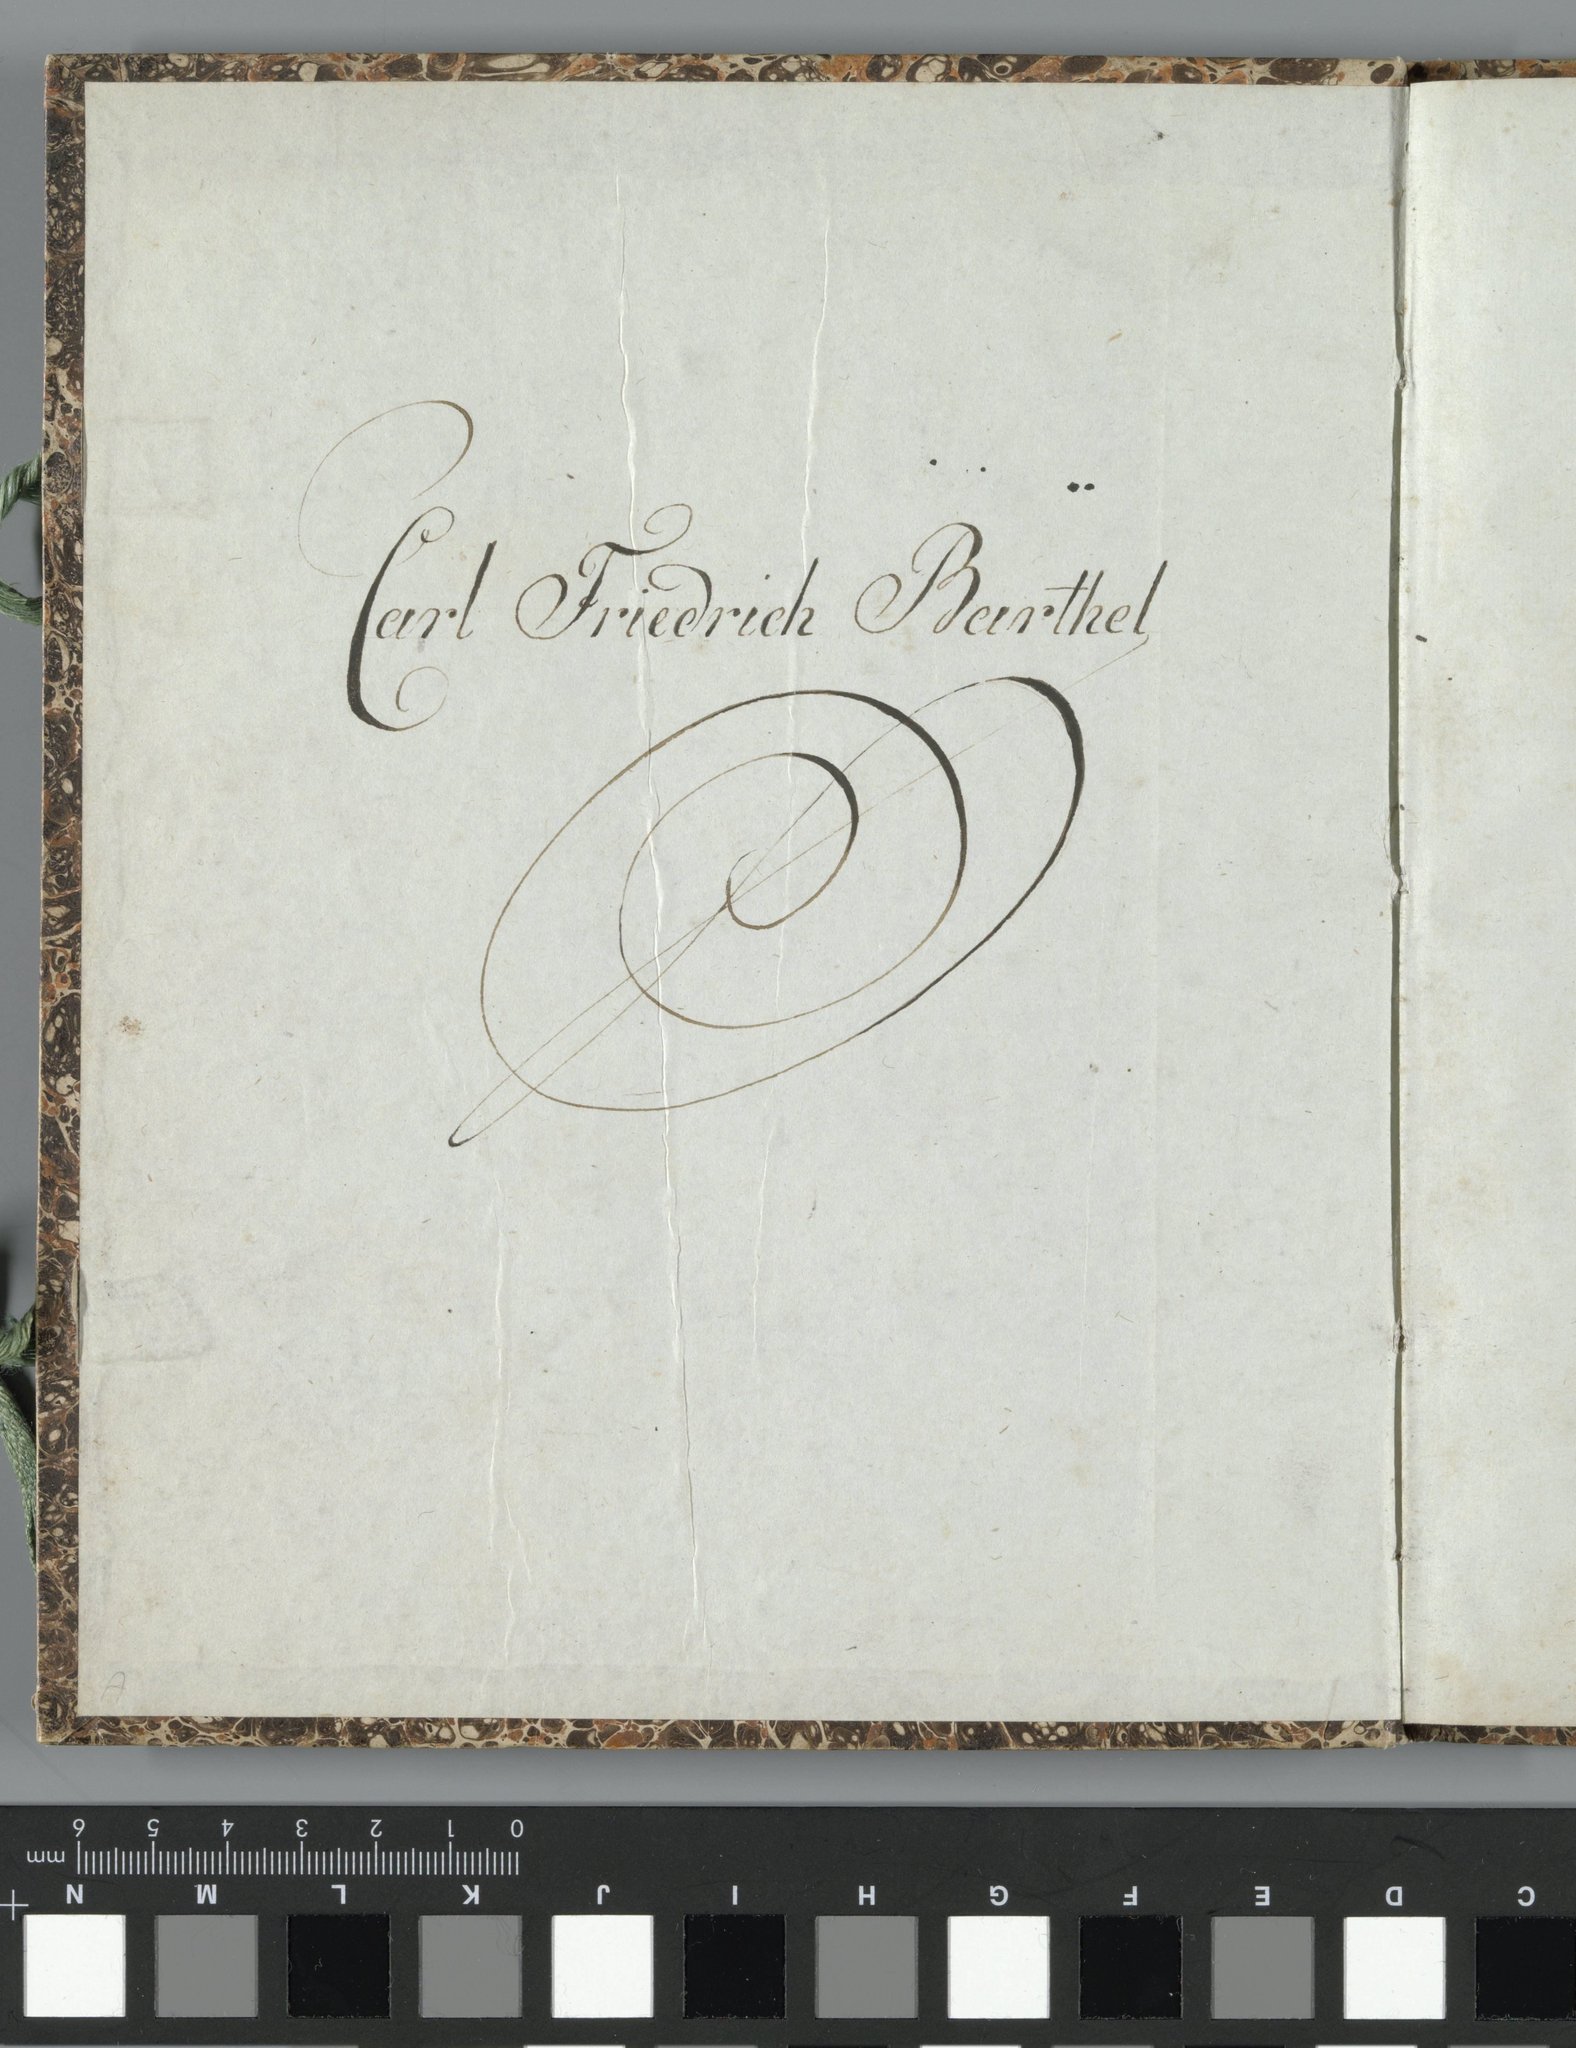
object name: endleaf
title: Schutblad uit een band met 17 bladen met tekeningen van juwelen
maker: carl friedrich bärthel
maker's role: draughtsman, jeweler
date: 1800-1810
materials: ink, paper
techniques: pen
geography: augsburg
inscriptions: signature: ‘Carl Friedrich Bärthel’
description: Schutblad met daarop de tekst 'Carl Friedrich Barthel' van een band van karton beplakt met gemarmerd papier met daarin bladen van licht blauw getint papier. Zeventien bladen zijn voorzien van tekeningen van juwelen.